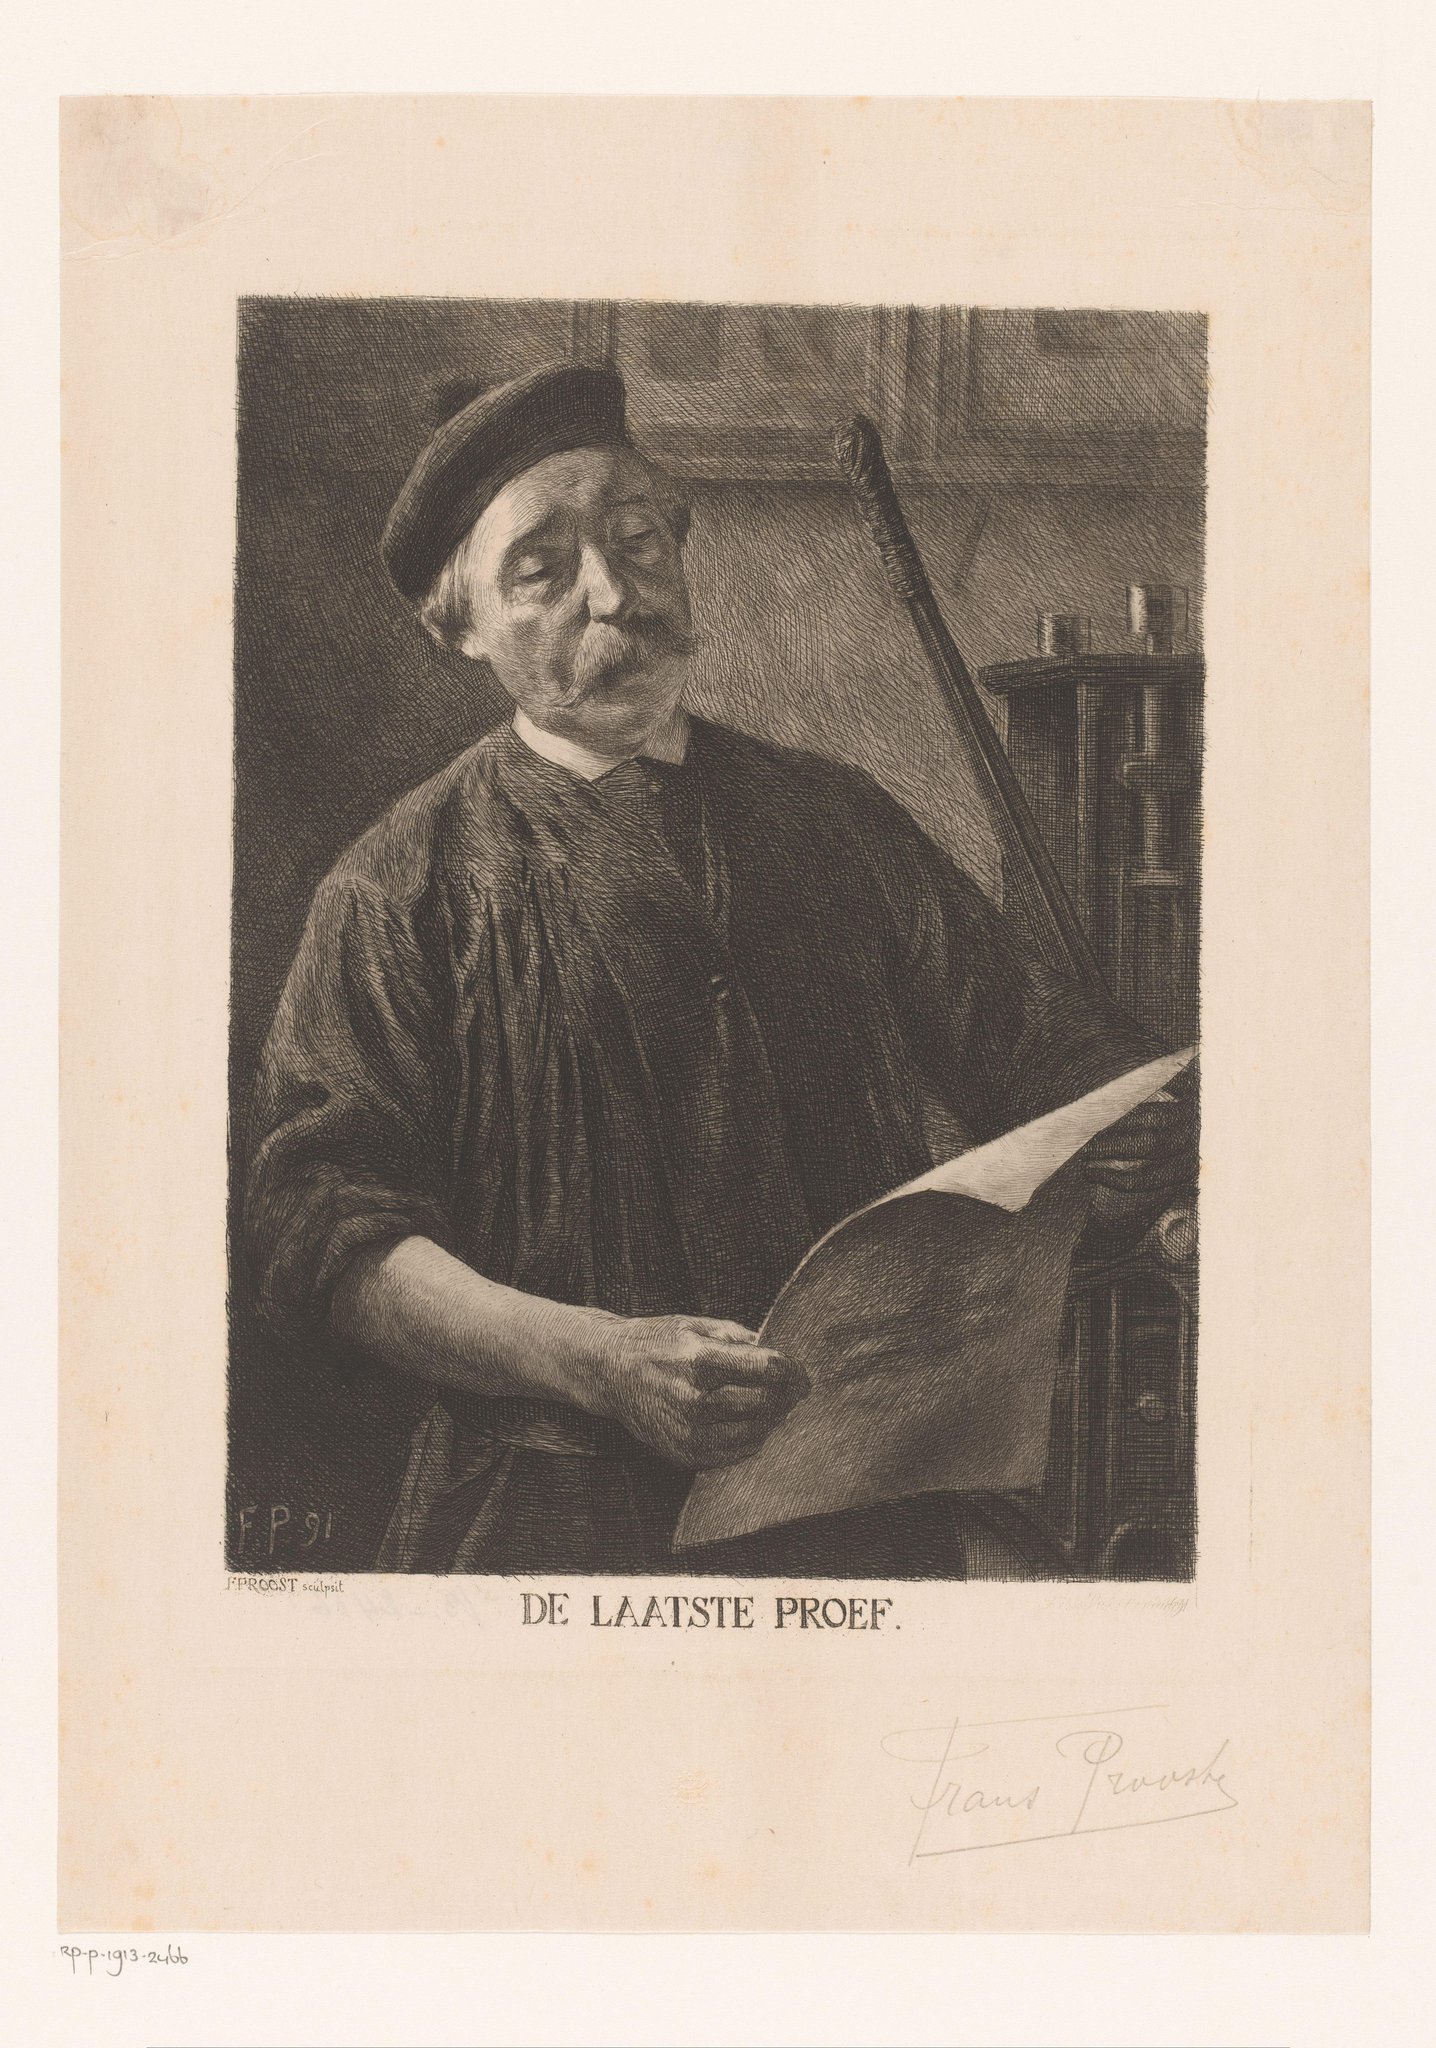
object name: print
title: Drukker bestudeert een proefdruk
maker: frans proost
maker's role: painter, print maker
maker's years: 1875-1941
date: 1891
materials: paper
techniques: drypoint, etching, intaglio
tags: printer, graphic artist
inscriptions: workshop stamp: ‘Antwerpsche Etsers 1880’, collector's mark: Lugt 2228